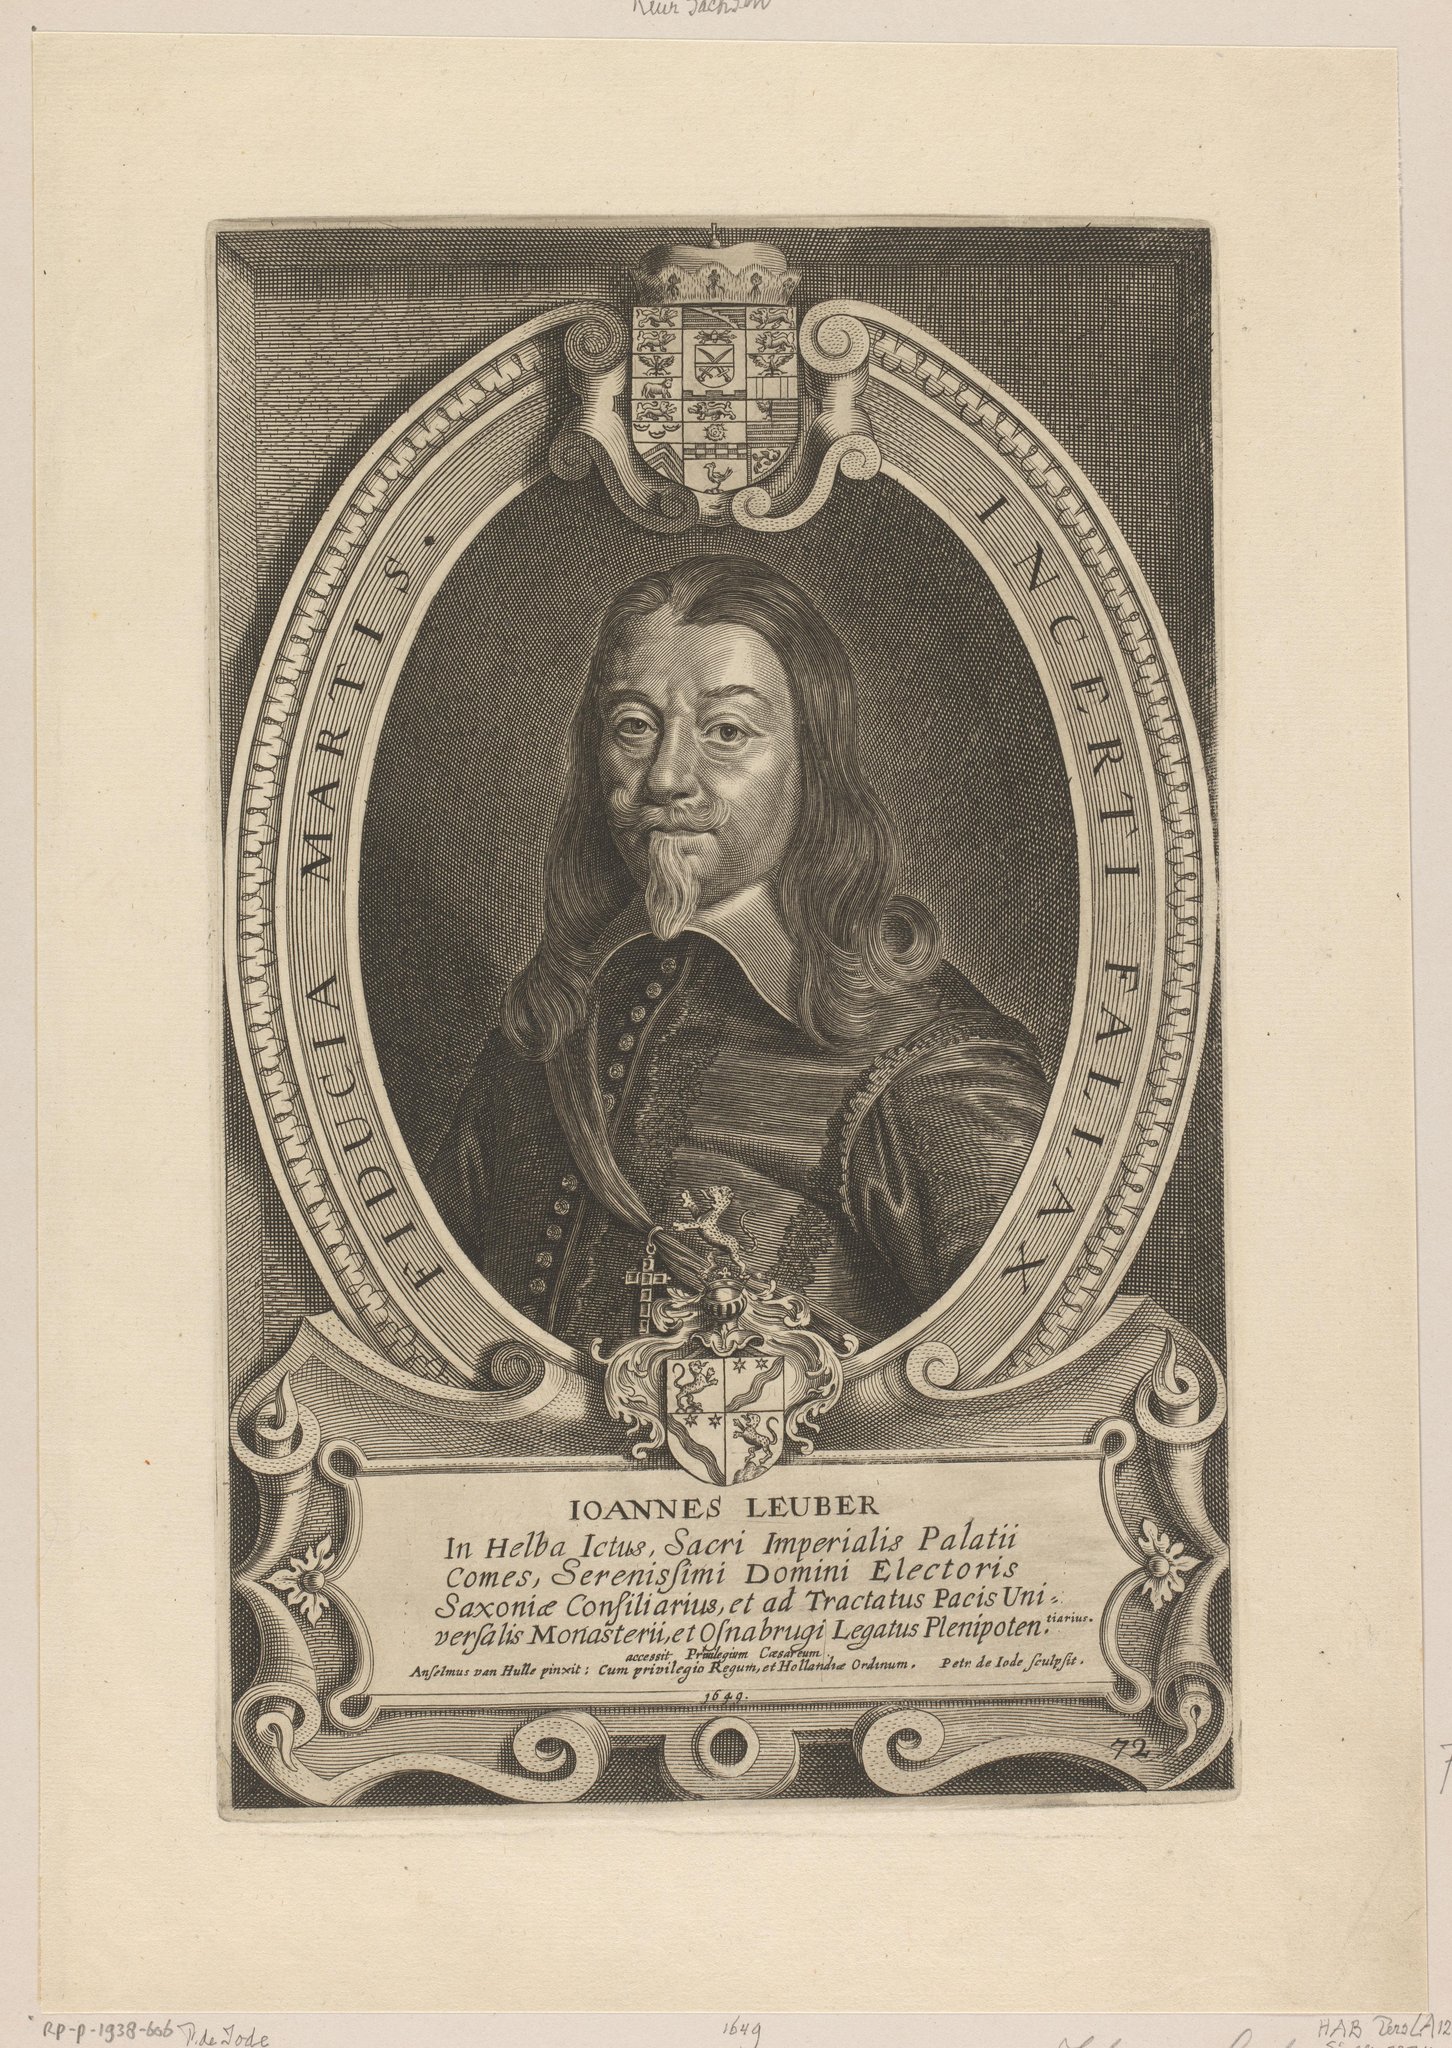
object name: print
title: Portret van Johann Leuber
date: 1713-1717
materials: paper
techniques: engraving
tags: official; civil servant; functionary (in general), historical persons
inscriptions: collector's mark: Lugt 2228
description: Prent is gebruikt in verschillende series. De huidige staat is gebruikt in de hieronder vermelde serie en uitgaven (7) en (8). (1)'Icones legatorum (...)', uitgegeven door Daniel Middeler in 1648 in Antwerpen. (2)‘Legati Celeberrimi’, uitgegeven door Daniel Middeler in 1648 in Antwerpen. (3)‘Legati Celeberrimi’, waarschijnlijk uitgegeven in 1651, maar opnieuw met de vermelding door Daniel Middeler in 1648 in Antwerpen. (4)‘Legati Celeberrimi', waarschijnlijk uitgegeven in 1658, maar opnieuw met de vermelding door Daniel Middeler in 1648 in Antwerpen. (5) 'Pacificatores orbis Christiani, sive icones principum, ducum et legatorum, qui Monasterii atque Osnabrugae (...)', uitgegeven door Pieter van der Slaart in 1696 in Rotterdam. (6) 'Pacificatores orbis Christiani, sive icones principum, ducum et legatorum, qui Monasterii atque Osnabrugae (...)', uitgegeven door Pieter van der Slaart in 1697 in Rotterdam. (7) 'Pacificatores orbis Christiani, sive icones principum, ducum et legatorum, qui Monasterii atque Osnabrugae (...)', waarschijnlijk uitgegeven circa 1713, maar opnieuw met vermelding van Pieter van der Slaart in 1697 in Rotterdam. De platen in deze uitgave zijn voor het eerst genummerd. (8) 'Les hommes illustres qui ont vécu dans le XXIIe siècle (...)', uitgegeven door David Mortier in 1717 in Rotterdam. Zie documentatie. Mogelijk zijn er nog meerdere uitgaven en staten van deze prent.